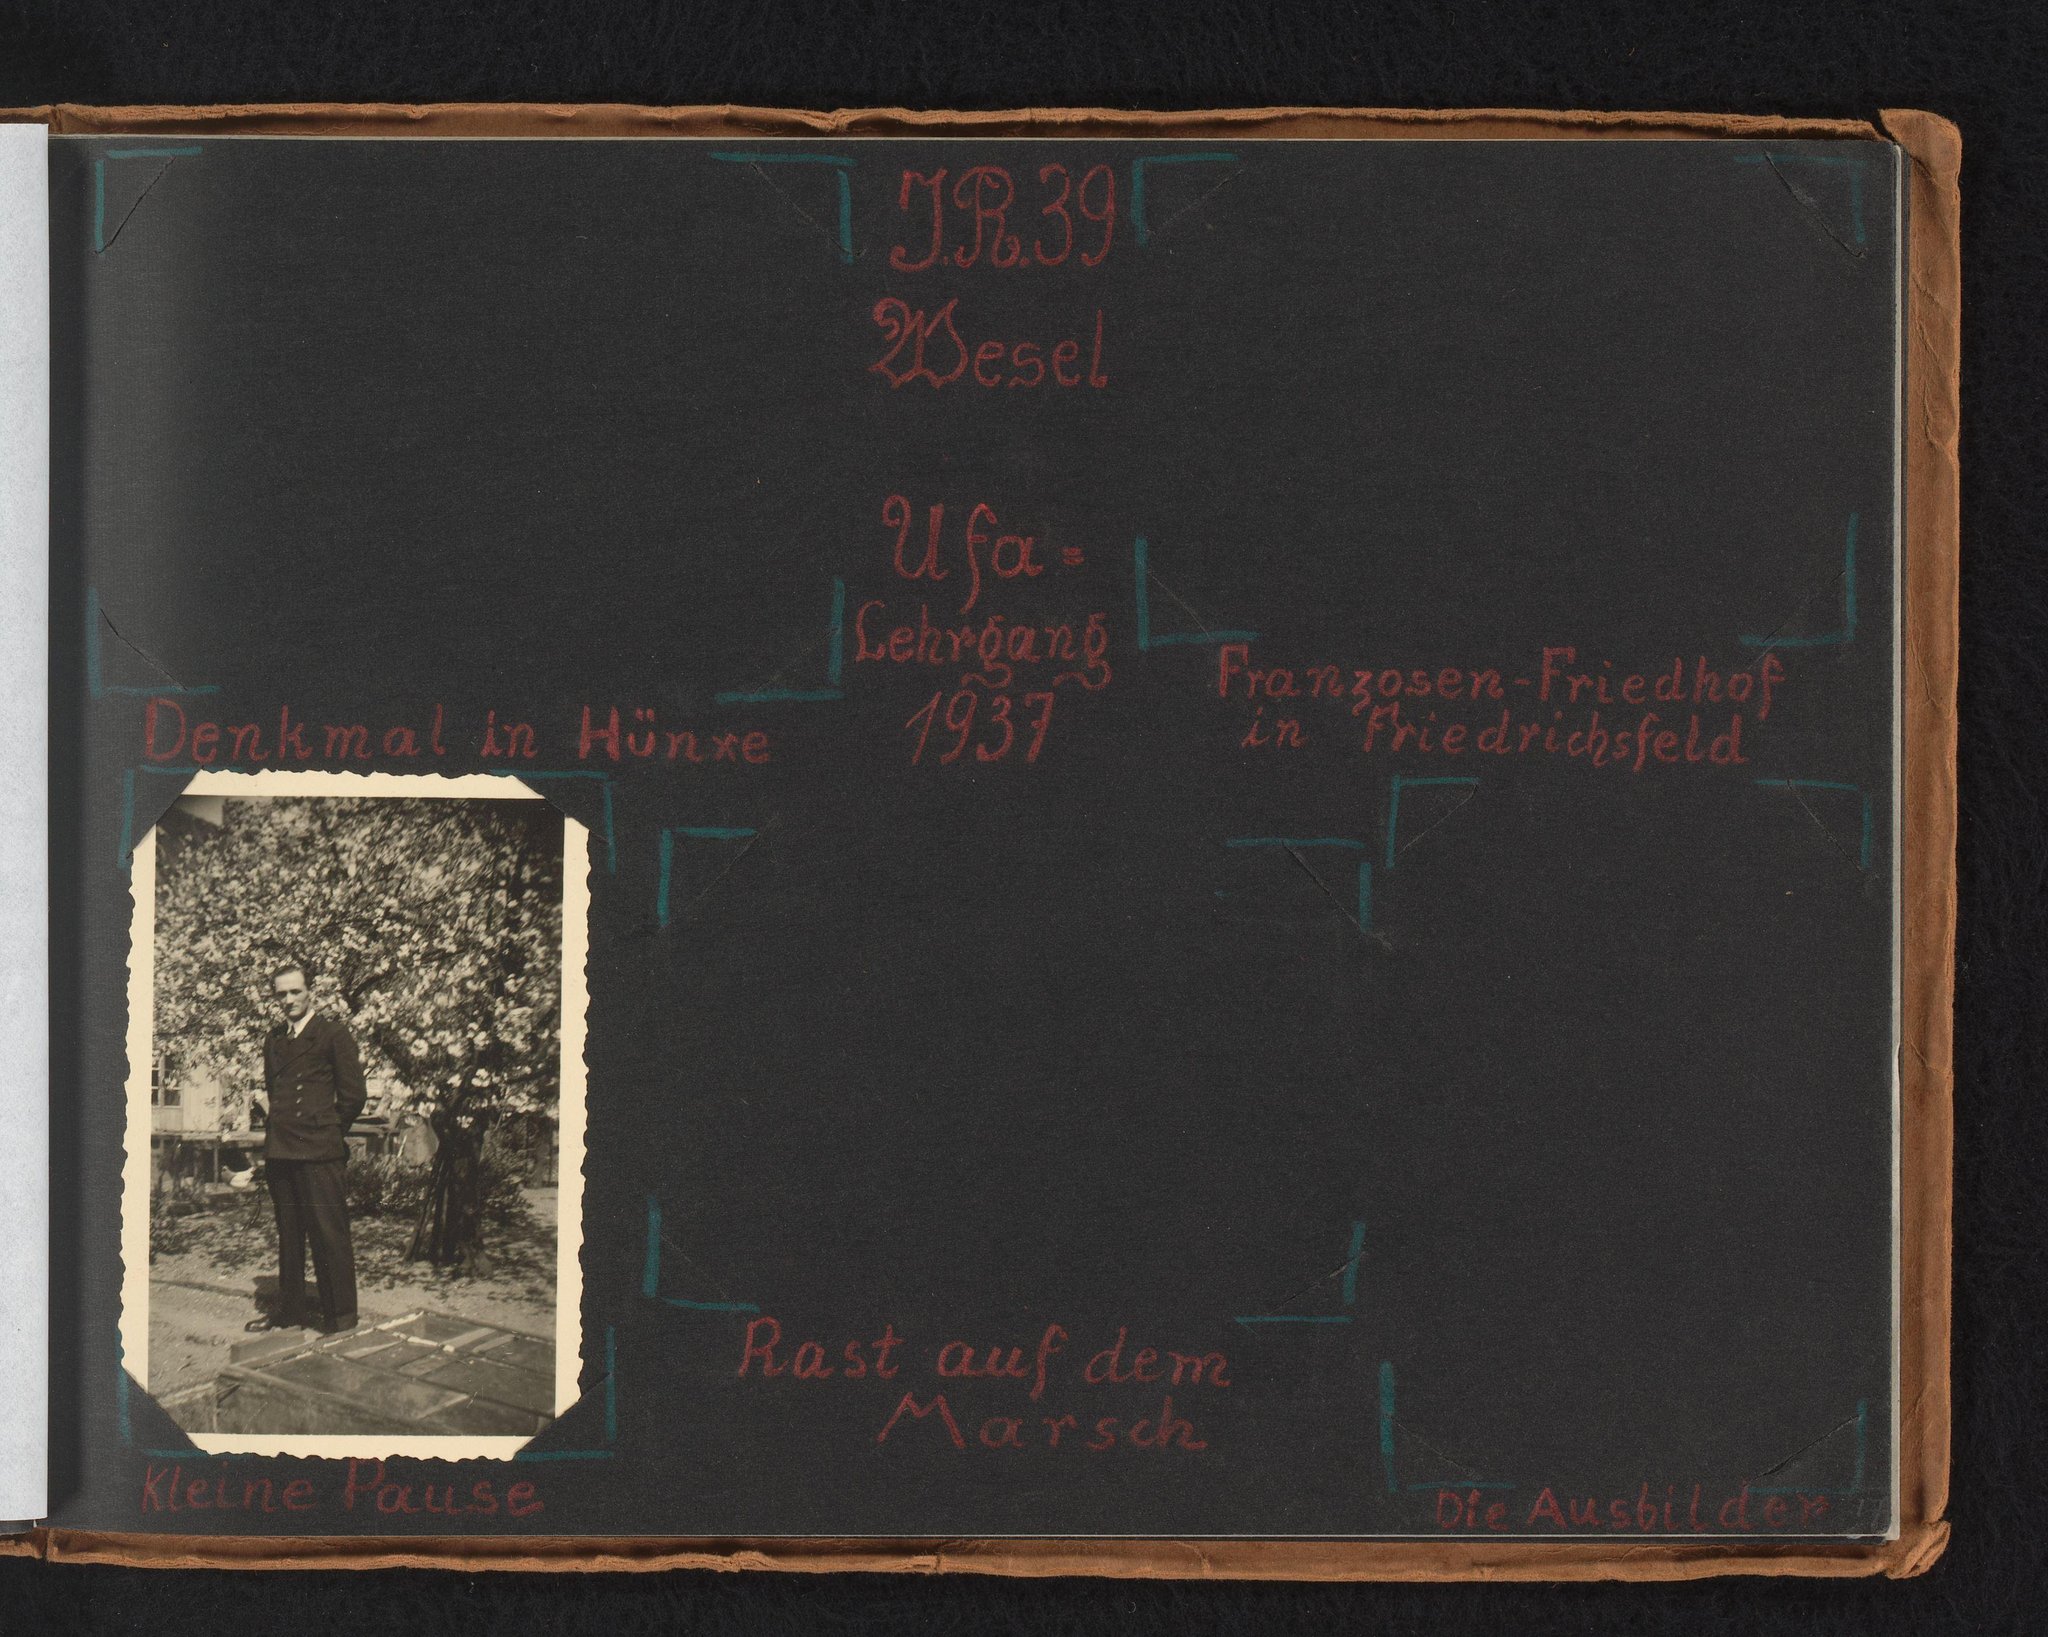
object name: photograph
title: Opleiding 1937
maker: Anonymous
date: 1937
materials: paper, photographic support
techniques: gelatin silver print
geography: germany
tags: werner neufang, military training, germany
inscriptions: inscription: ‘I.R. 39 Wesel / U fa. Lehrgang 1937 ...’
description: Albumblad een foto van Werner tijdens zijn militaire opleiding in 1937. De overige vier foto's die oorspronkelijk op dit blad zaten ingestoken ontbreken. Onderdeel van een fotoalbum over de Duitse Werner Neufang van de Kriegsmarine en de Nederlandse Thea Driesen.